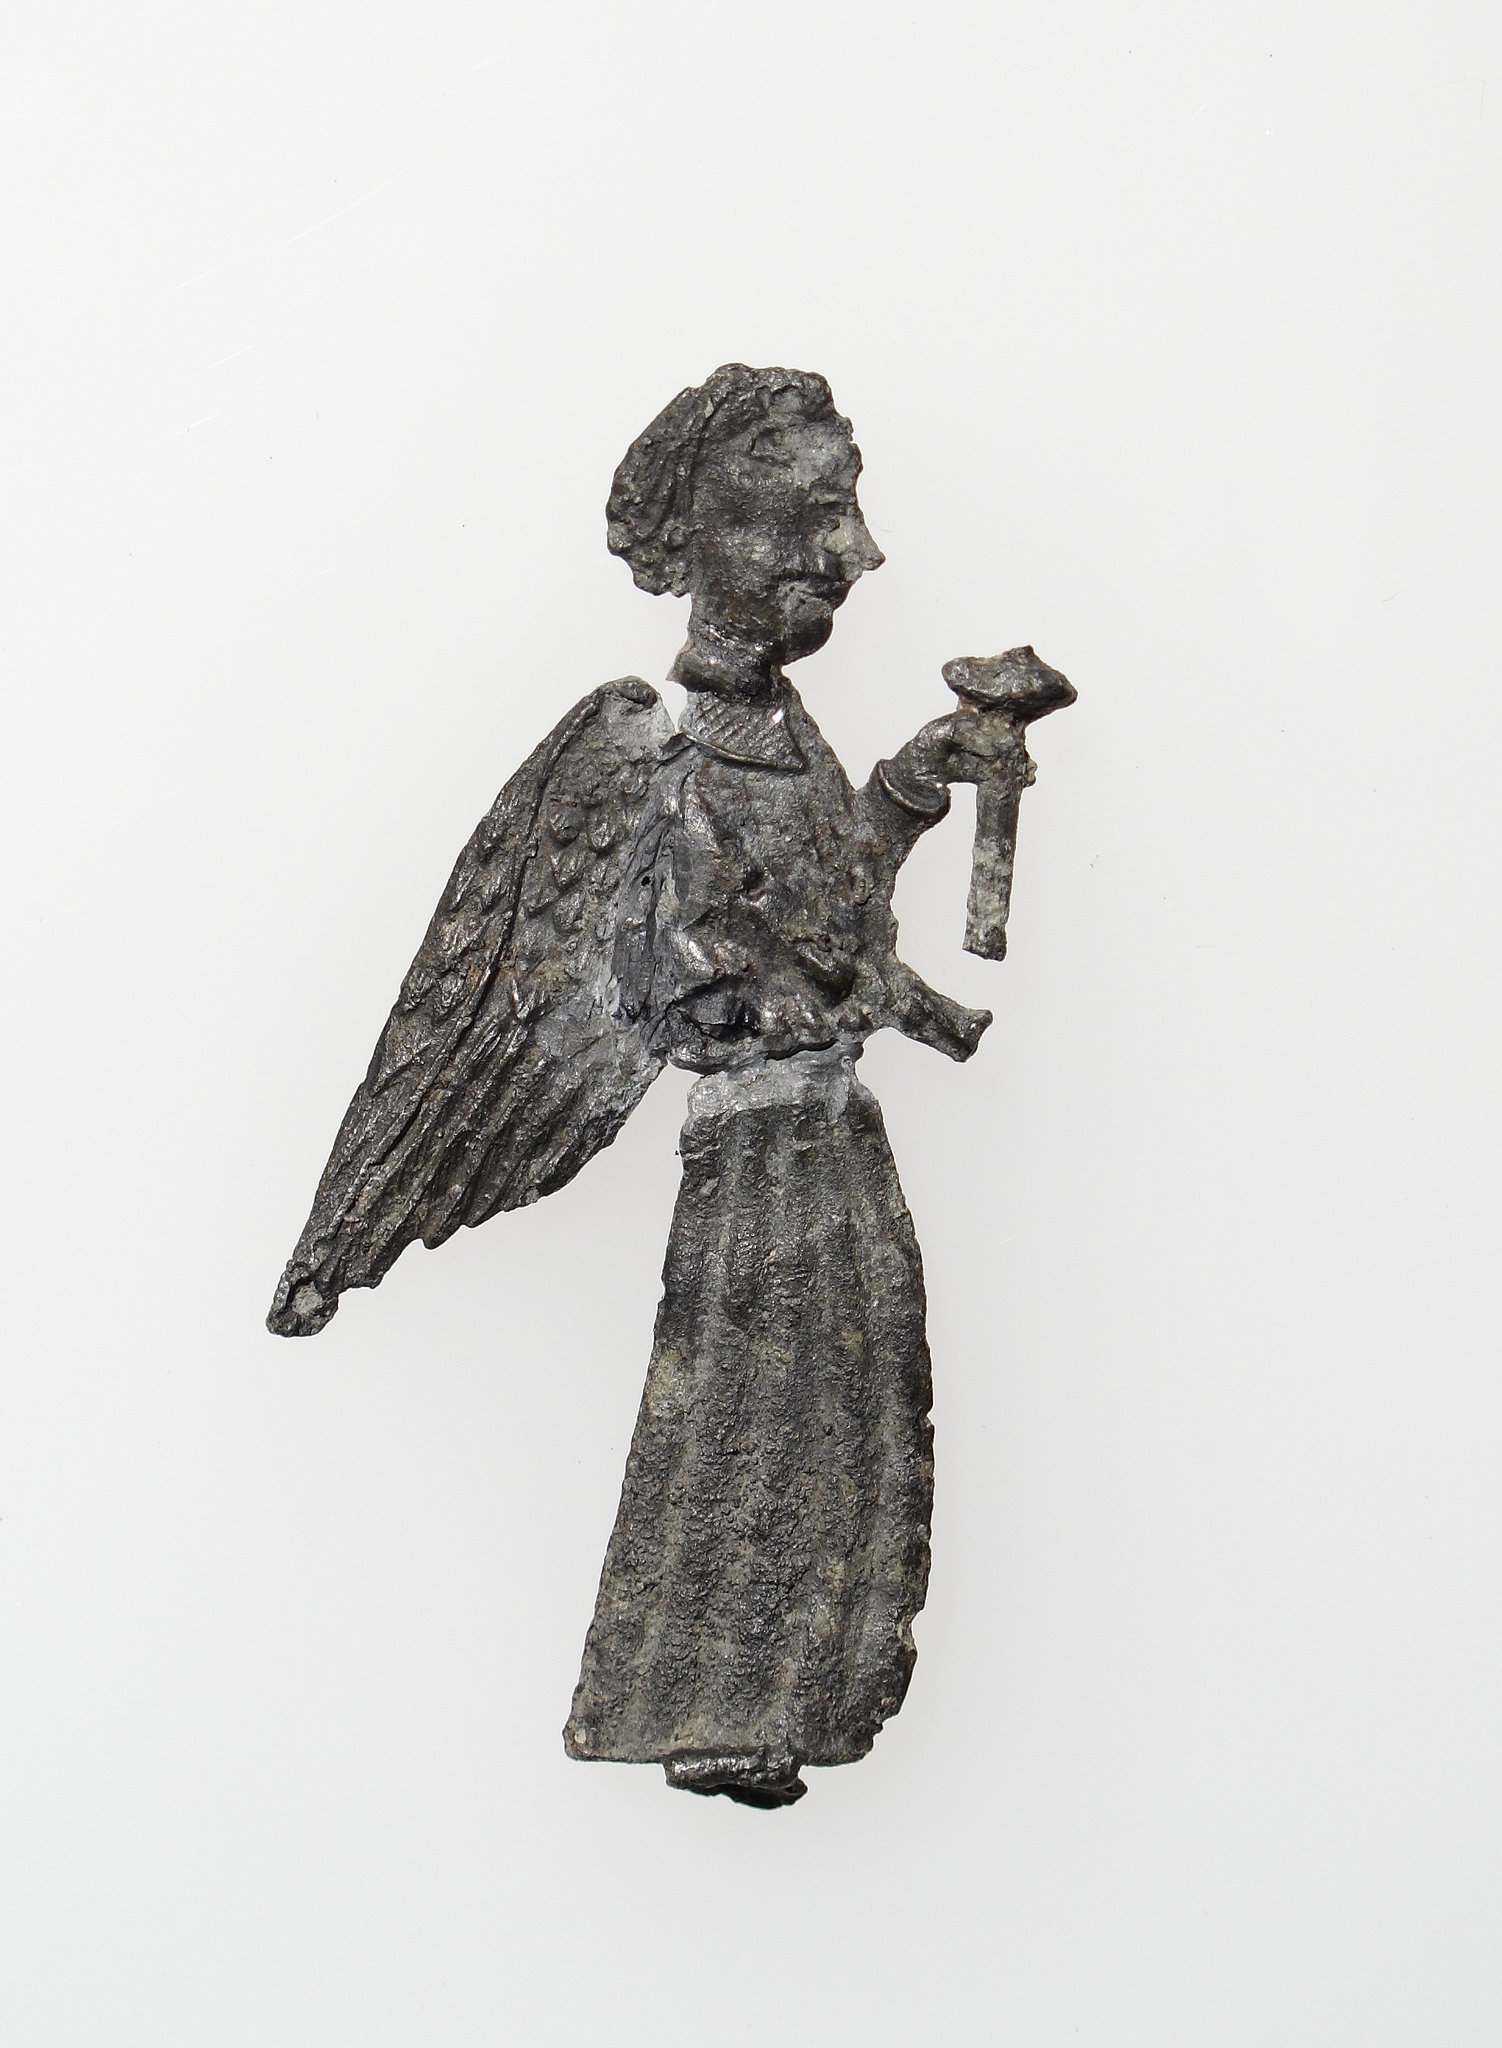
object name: pilgrim's badge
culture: french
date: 1301-1600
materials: lead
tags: angels